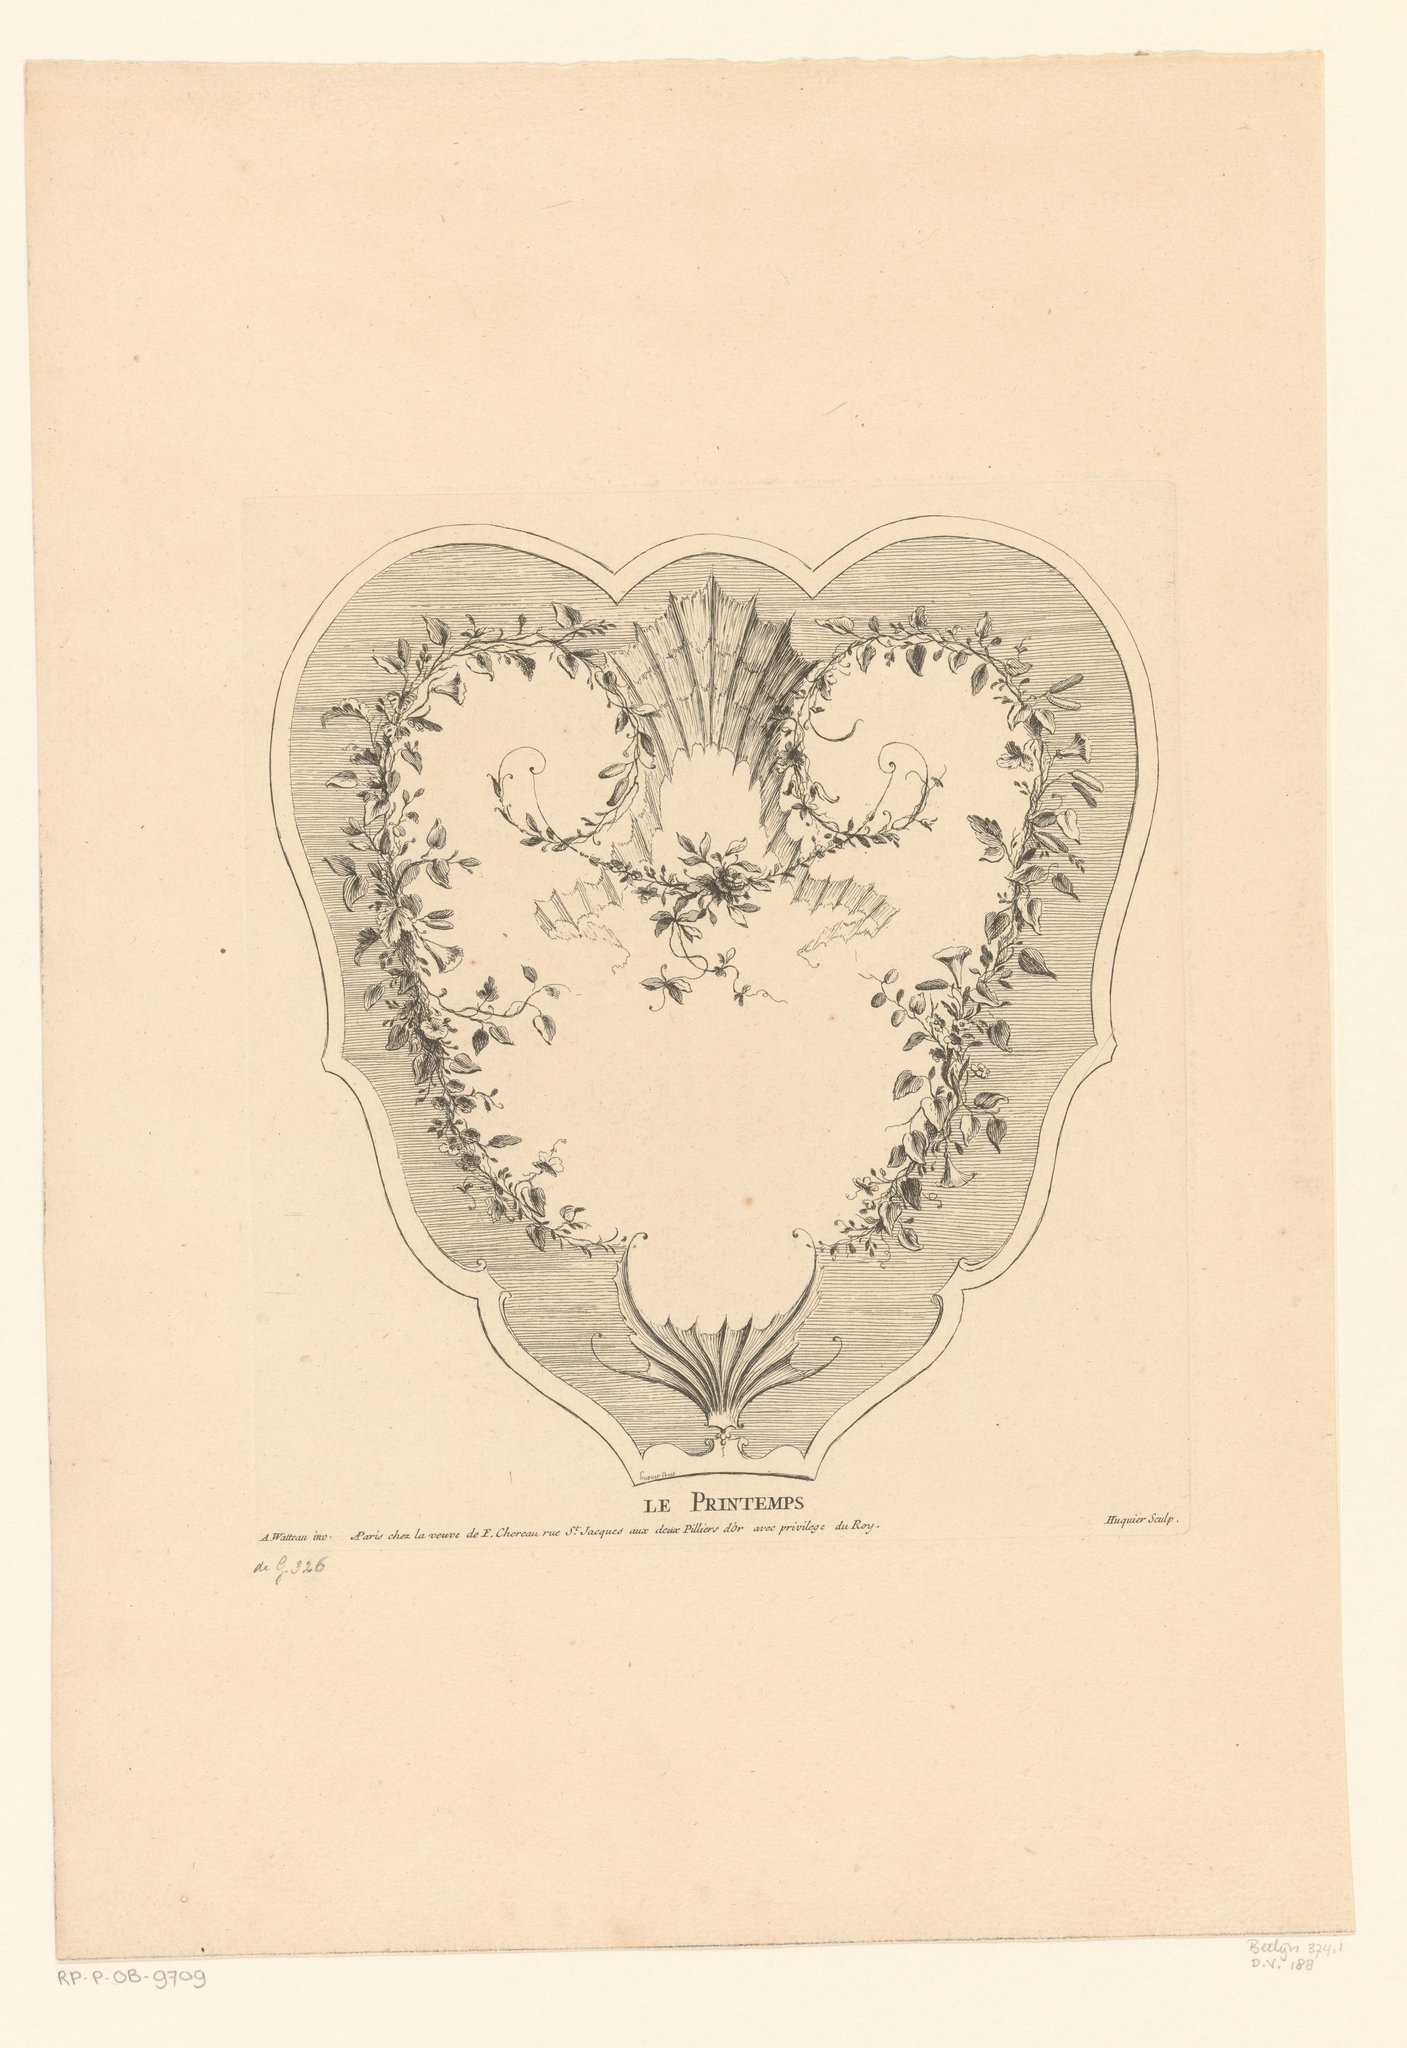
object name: ornament print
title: le Printemps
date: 1729-1755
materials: paper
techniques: etching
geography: paris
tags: spring, 'ver'; 'primavera' (ripa)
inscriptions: collector's mark: Lugt 2228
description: Hartvormige omlijsting met rocailles en bloemranken.